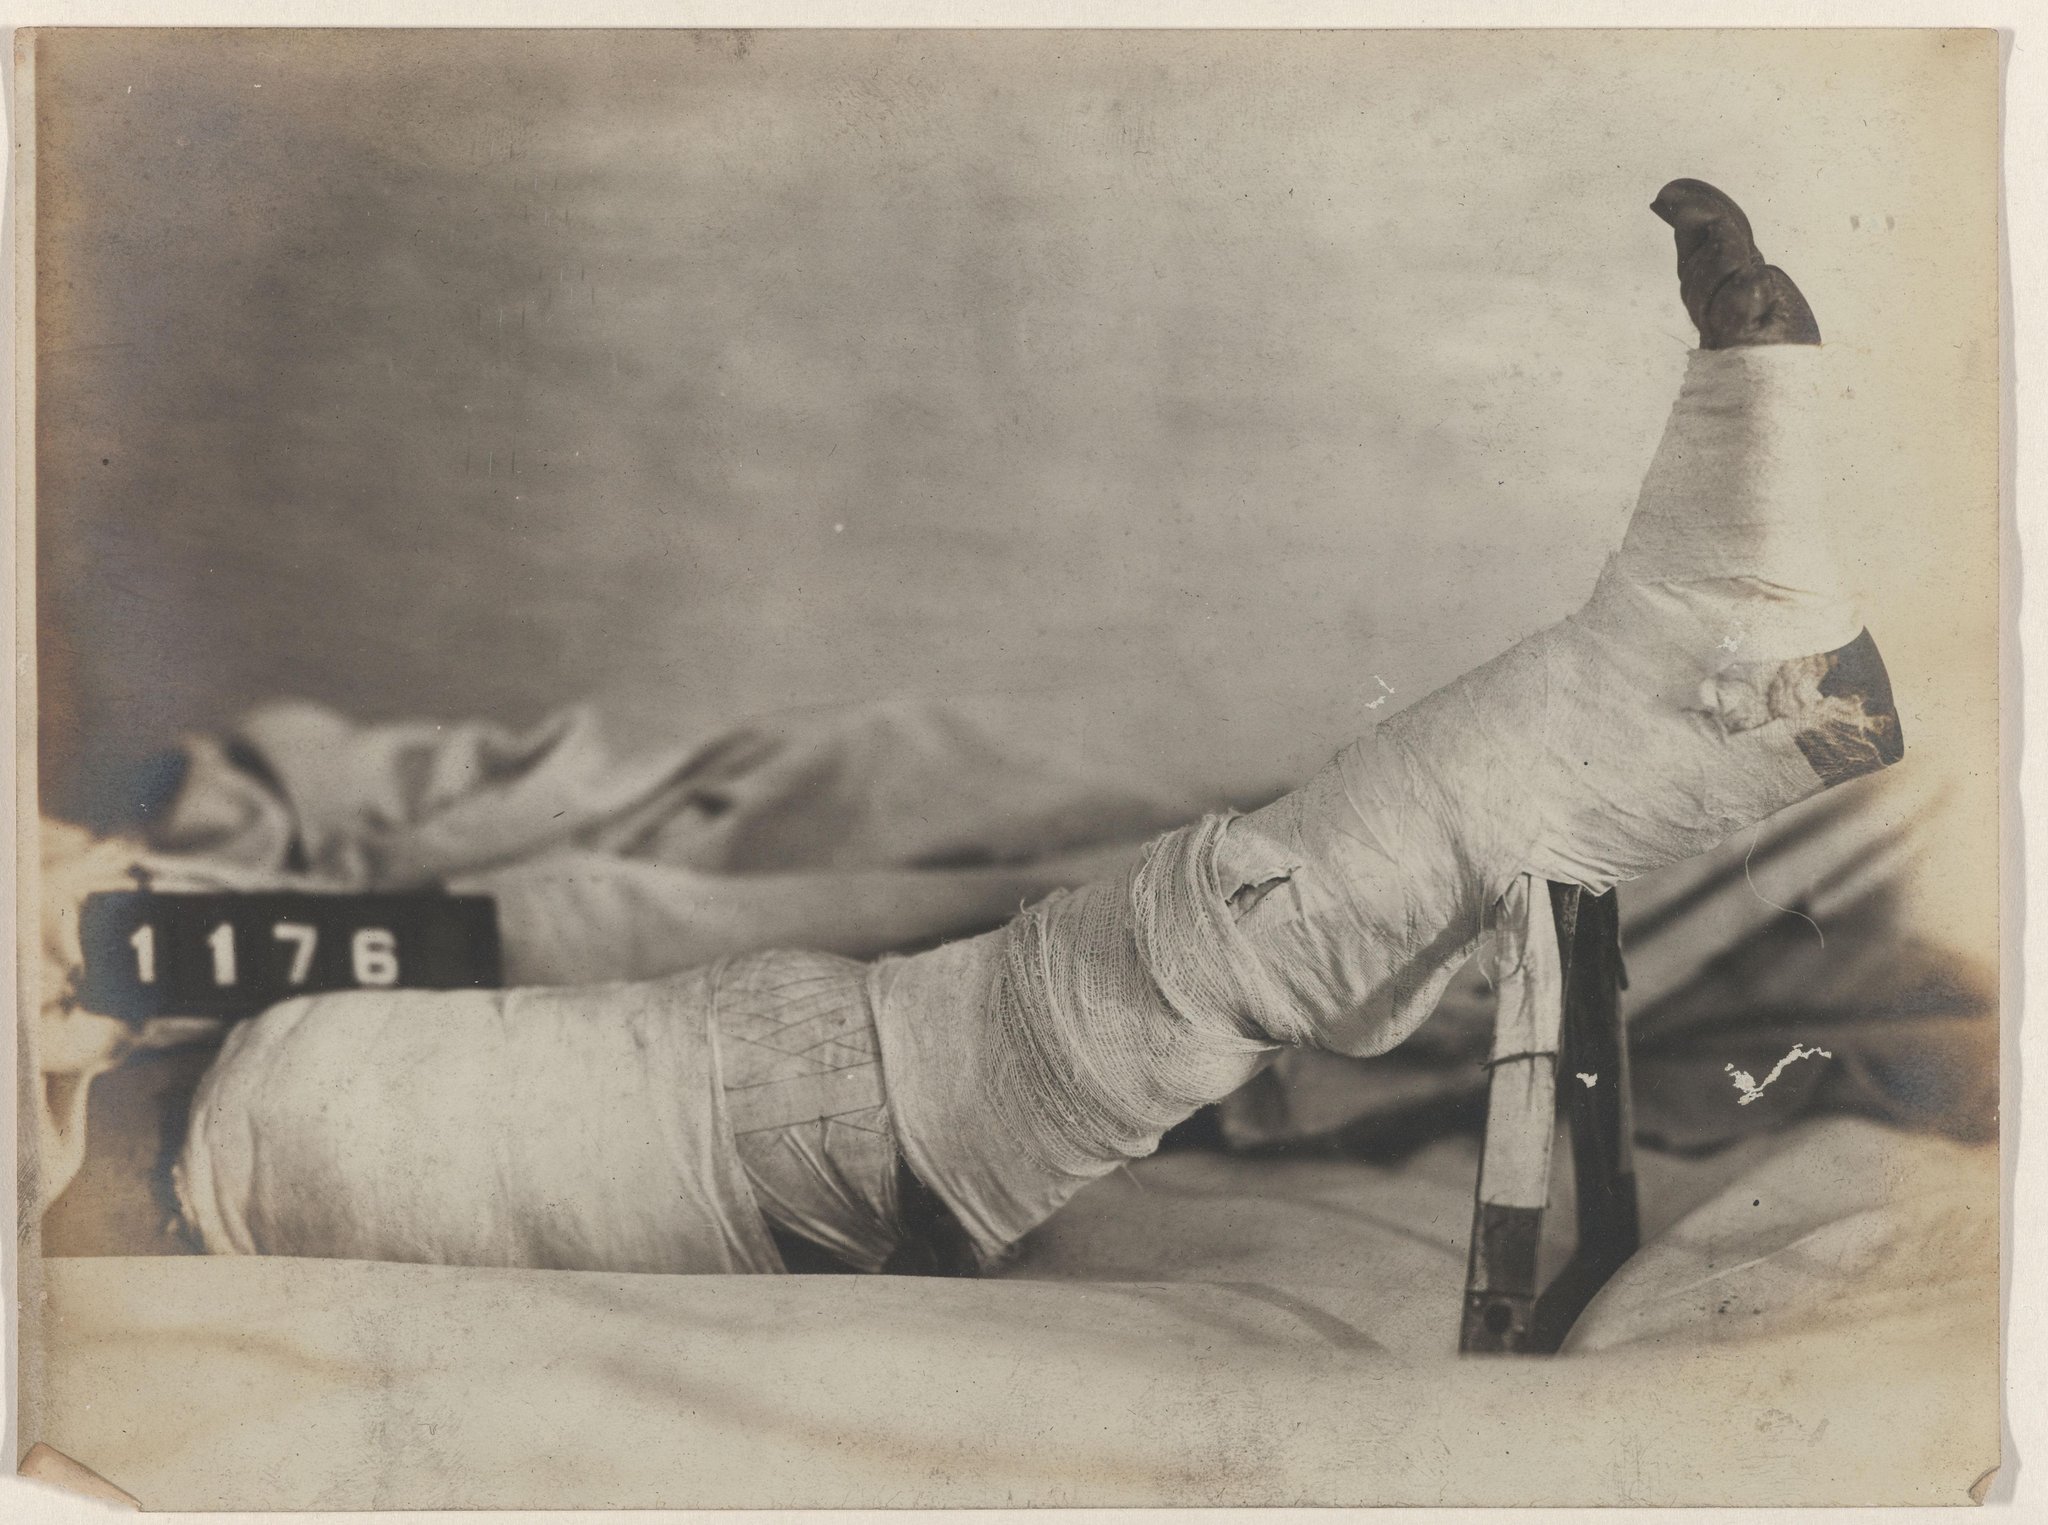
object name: photograph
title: Patiënt met verbonden been in ziekenhuis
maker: Anonymous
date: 1900-1920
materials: paper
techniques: gelatin silver print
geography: united states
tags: hospital, patient, sick person